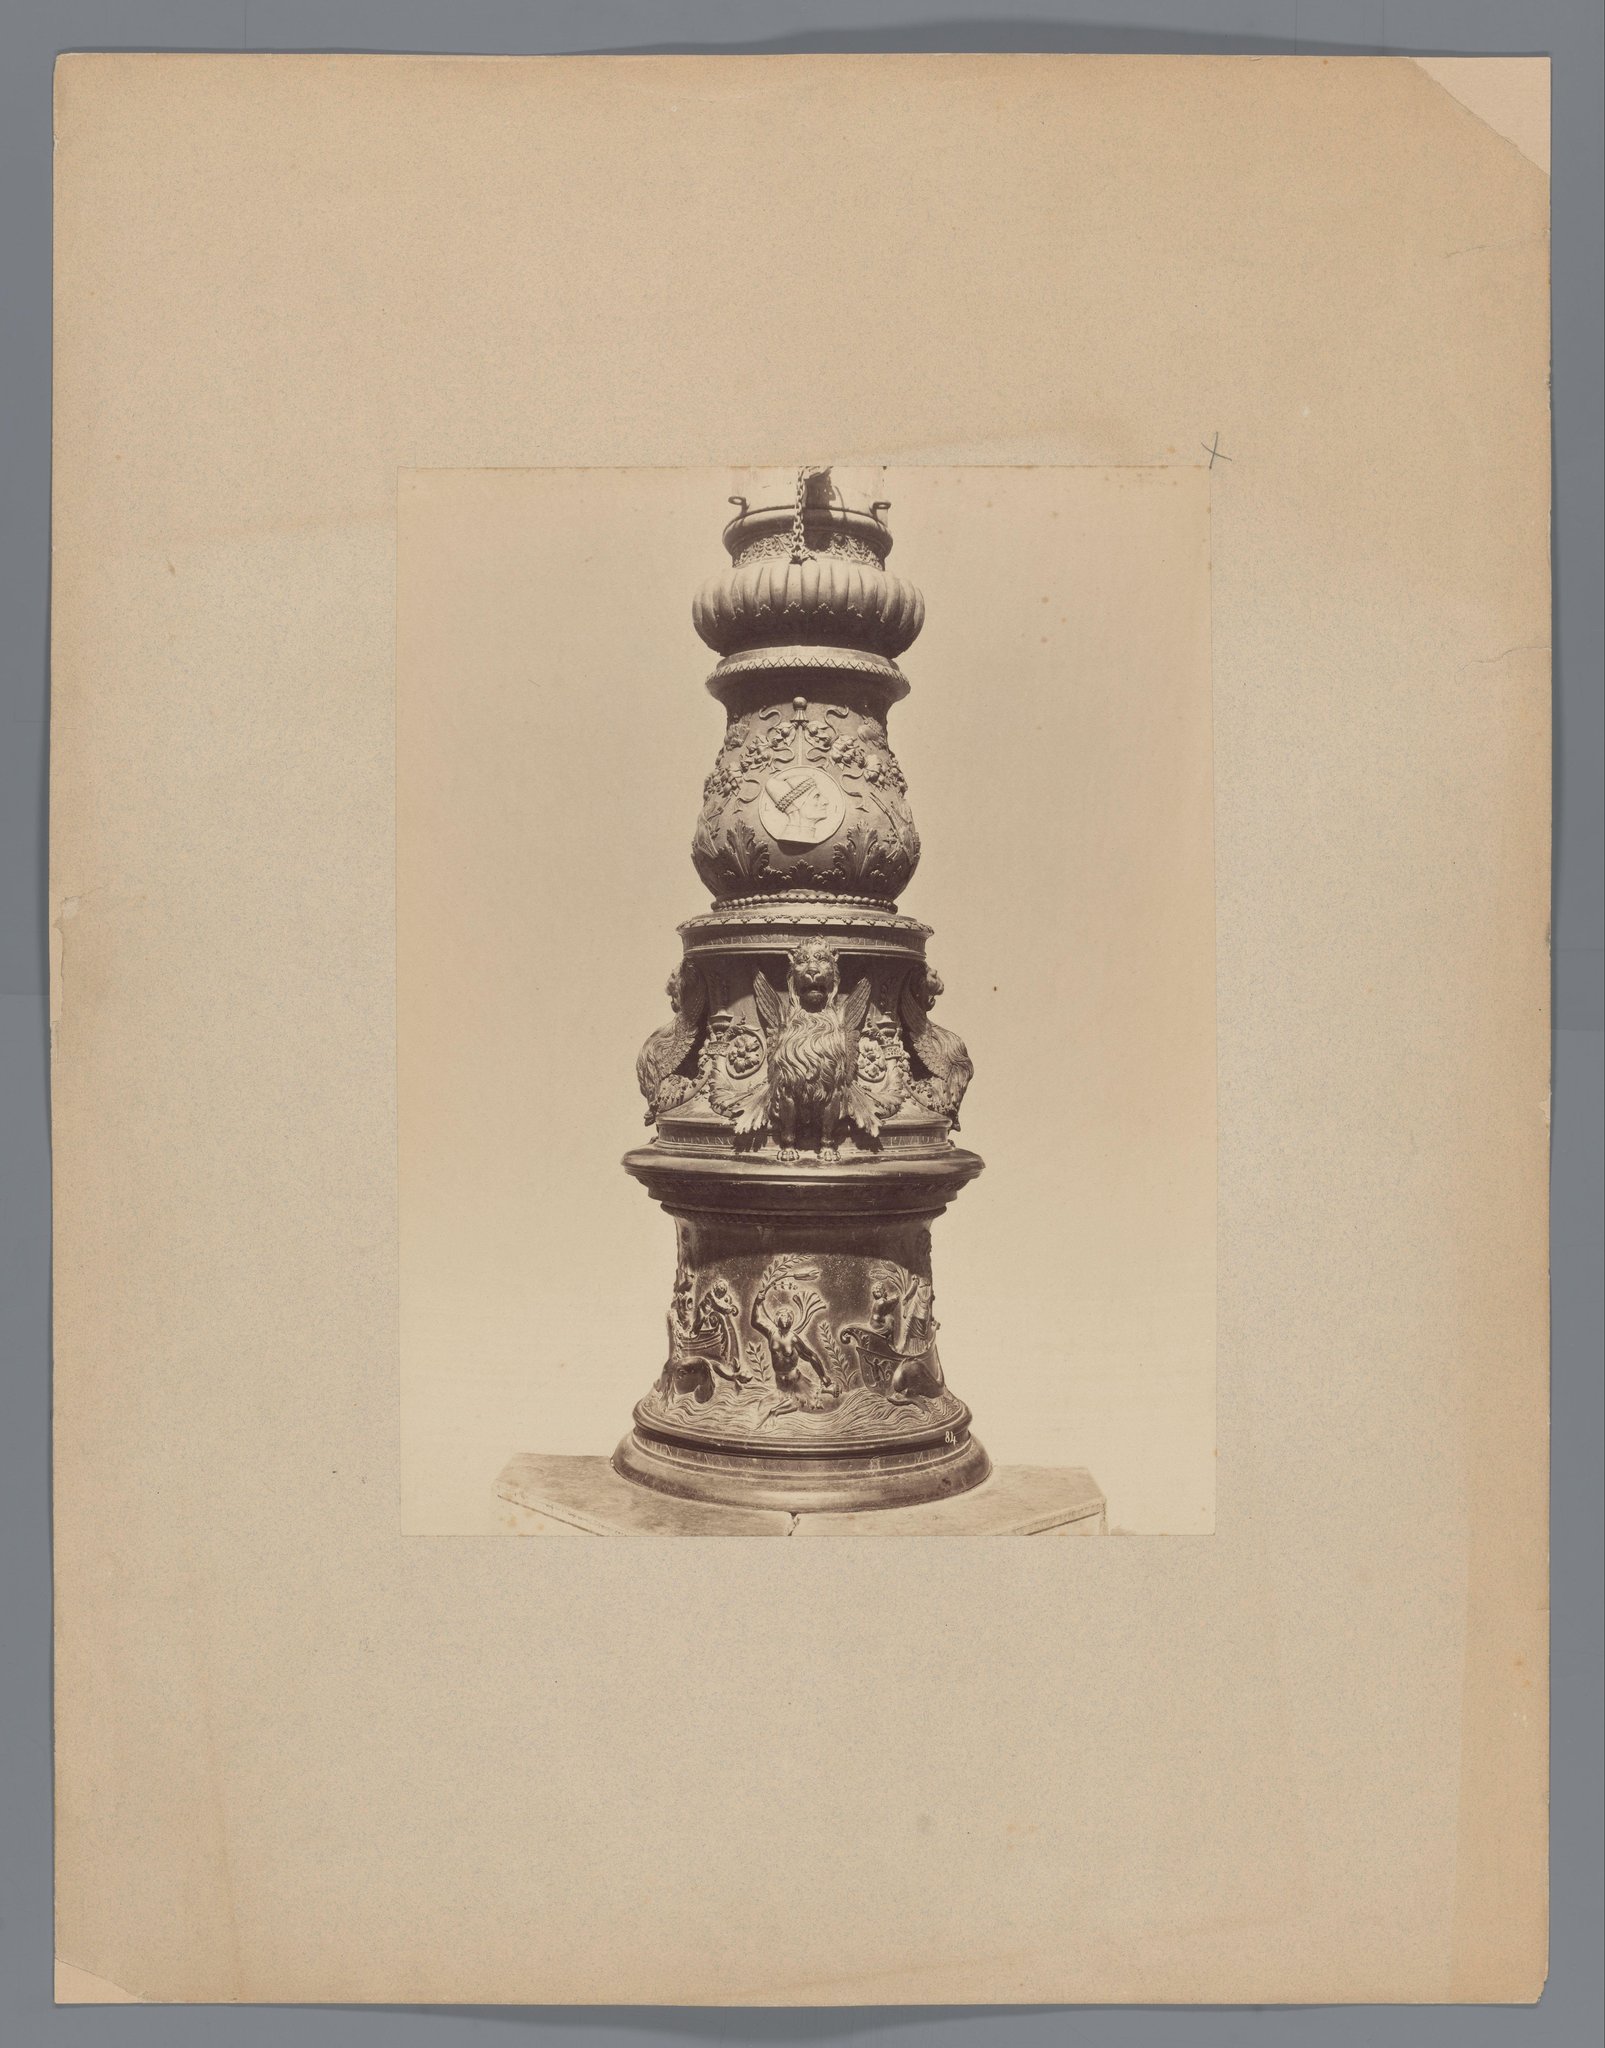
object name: photograph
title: Met reliëf gedecoreerde zuil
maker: carlo naya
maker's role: fotograaf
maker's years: 1816-1882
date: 1880-1900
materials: cardboard, paper, photographic support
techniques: albumen print